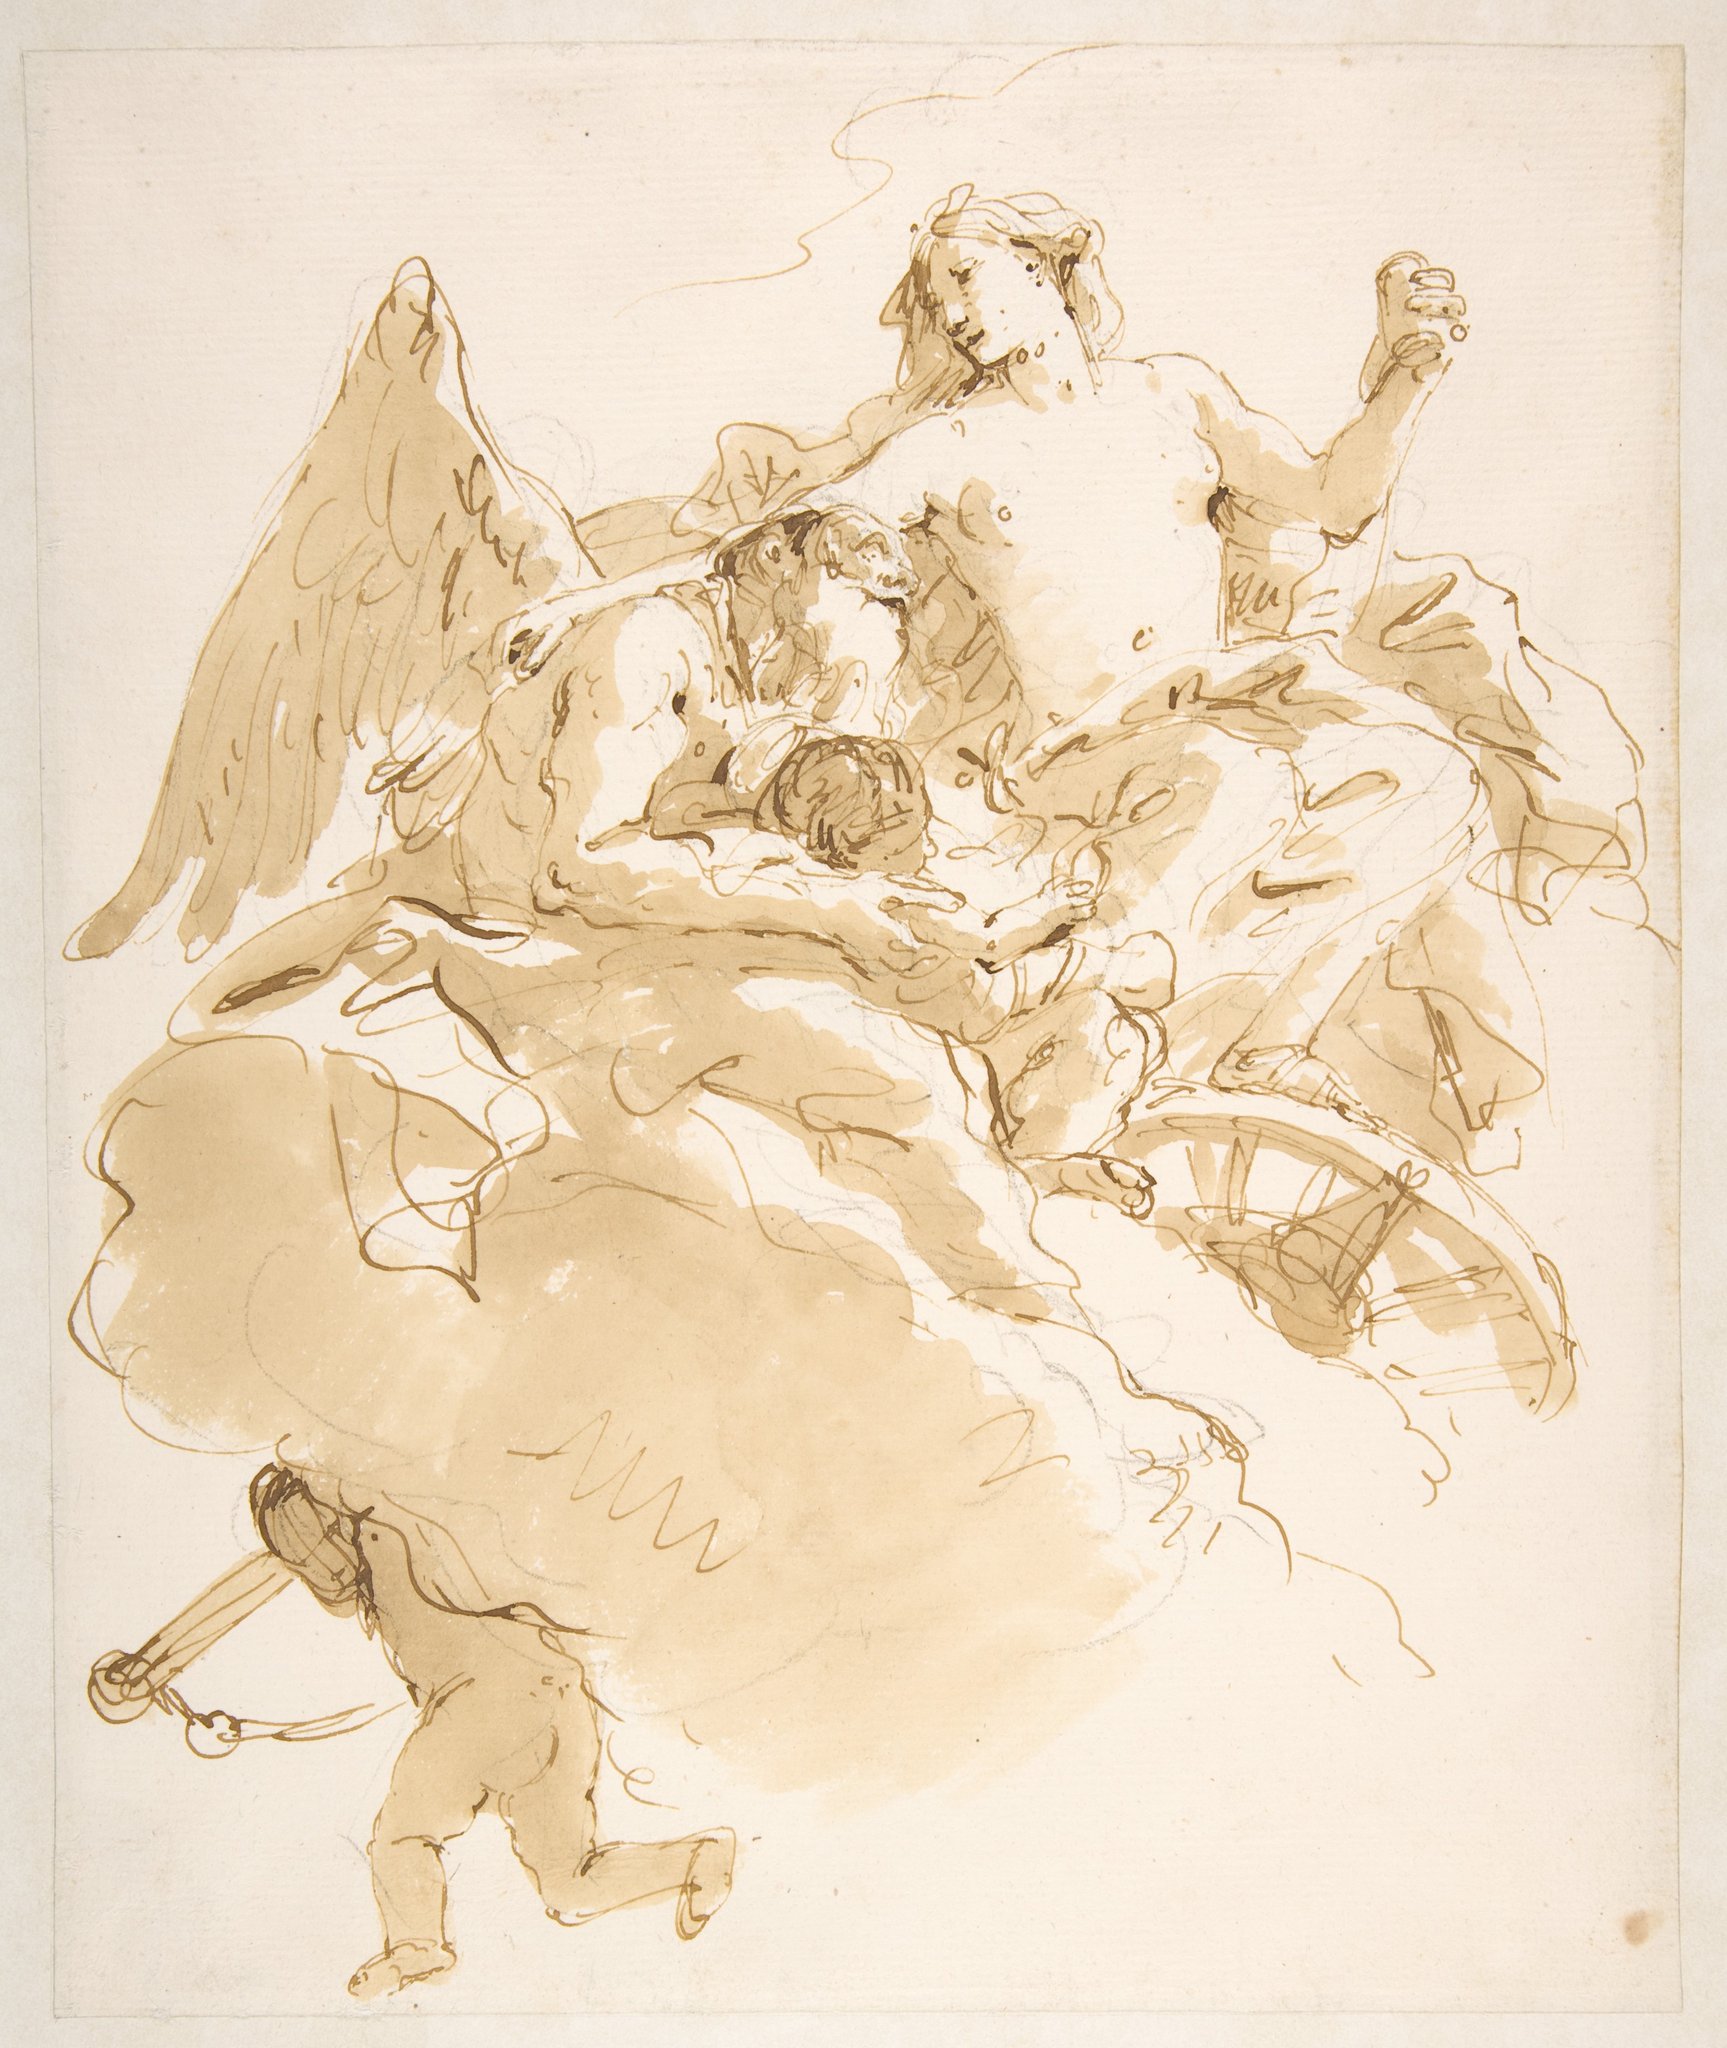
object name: drawing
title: Venus Entrusting an Infant to Time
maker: giovanni battista tiepolo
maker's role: artist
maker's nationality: italian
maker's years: 1696-1770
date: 1696-1770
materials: chalk, ink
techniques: brush, pen, wash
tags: infants,venus